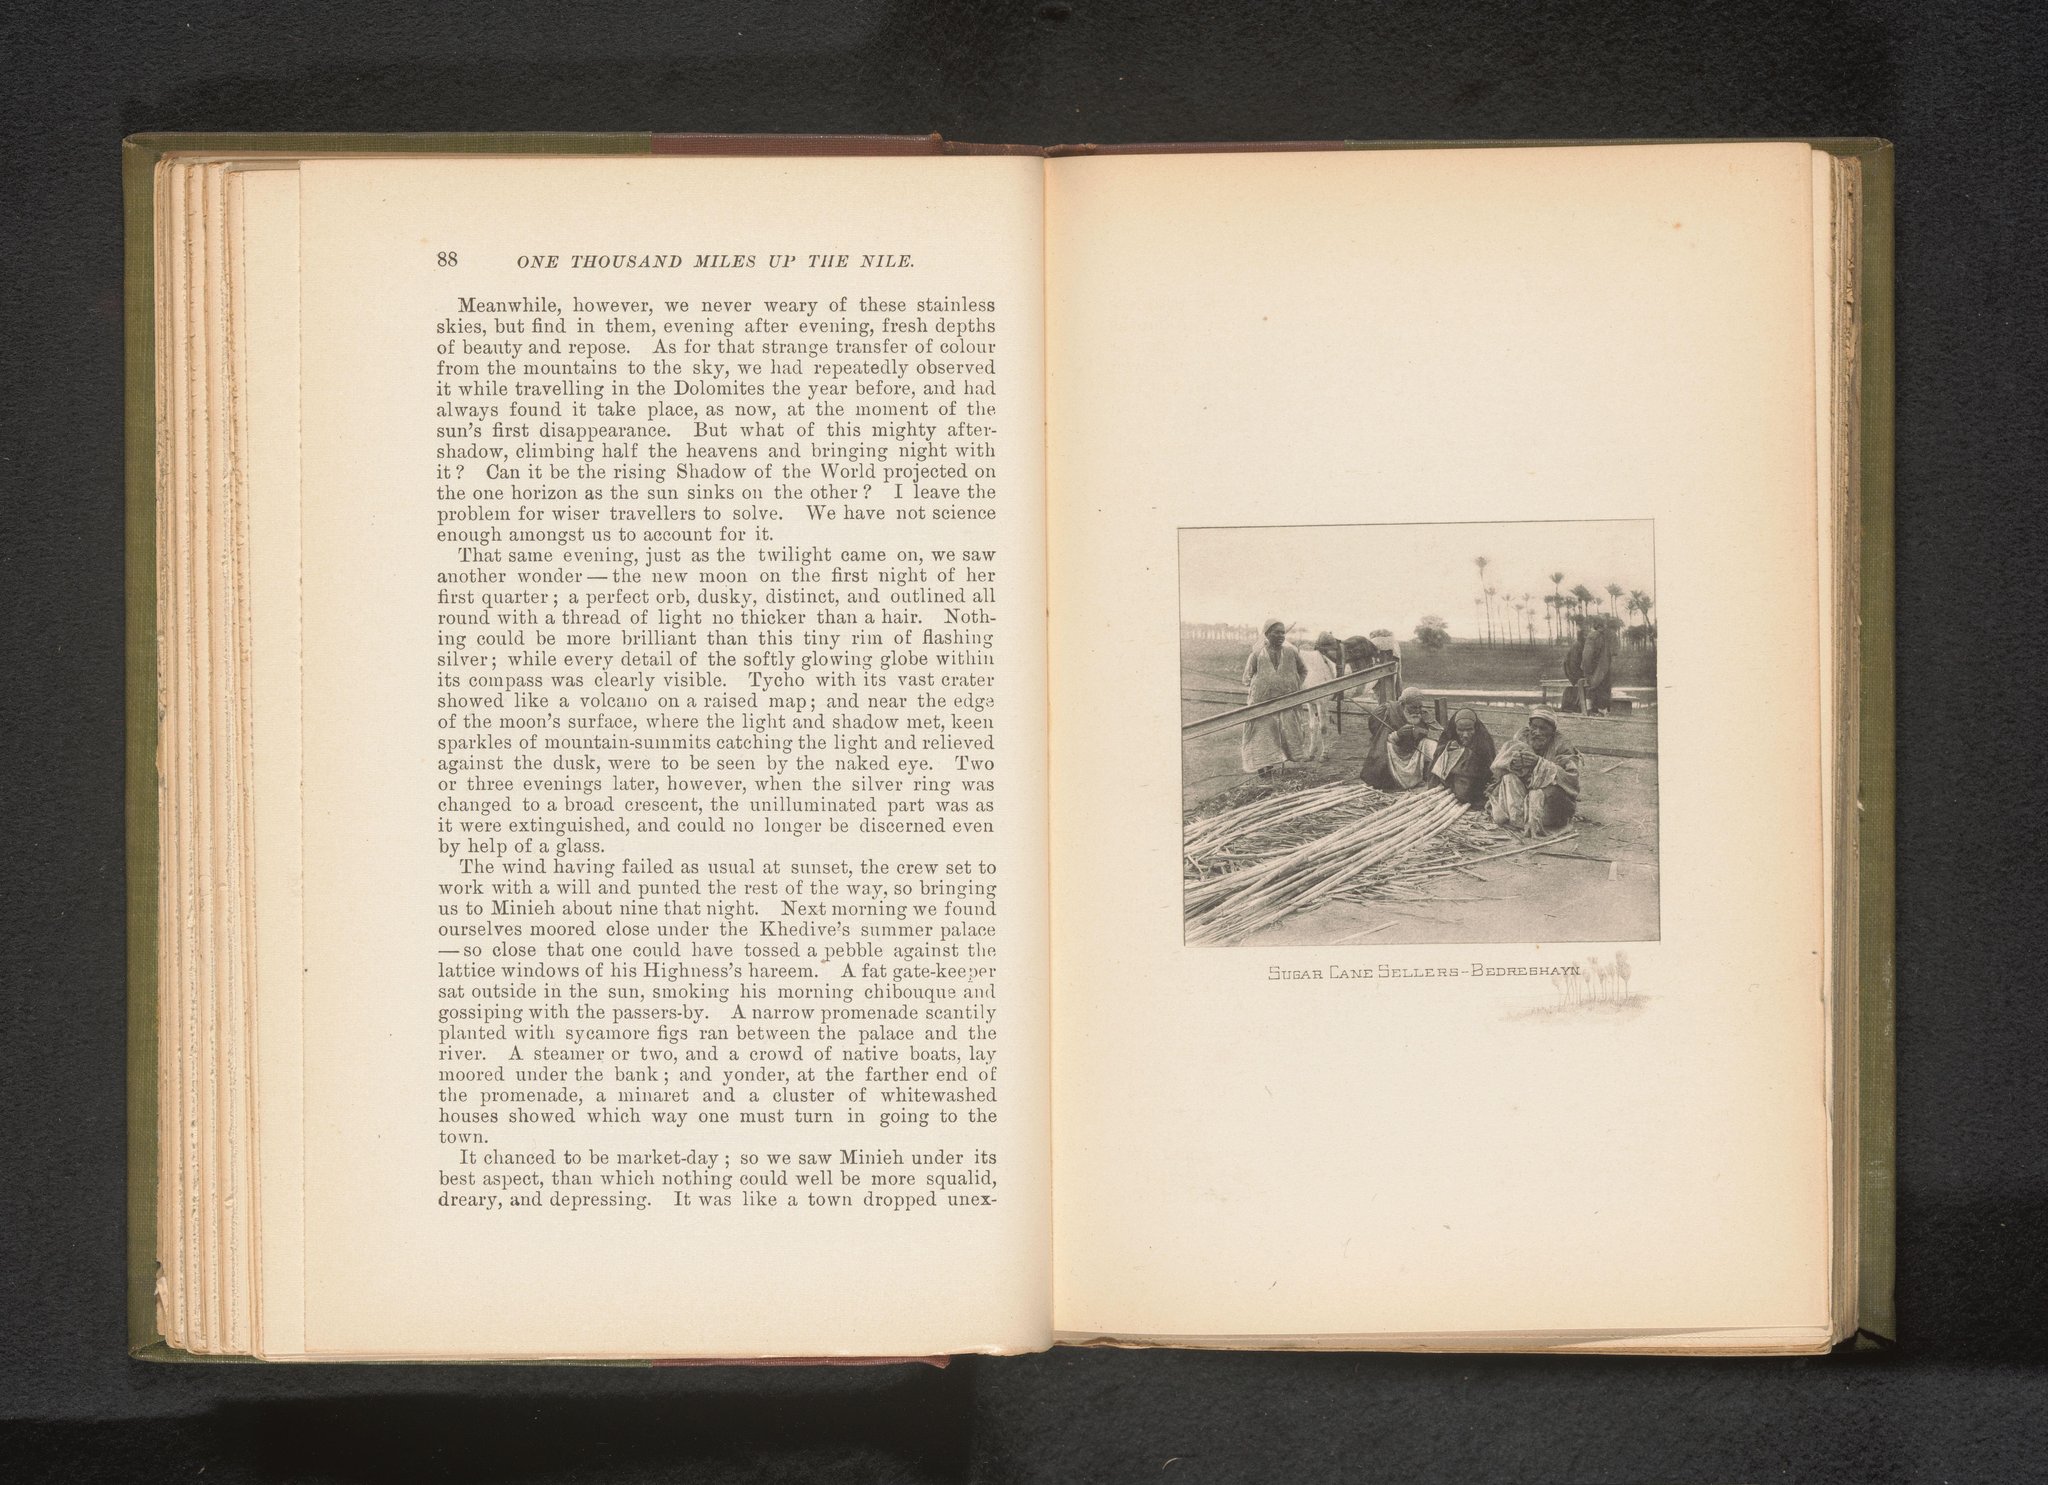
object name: photomechanical print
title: Sugar cane-sellers-Bedreshayn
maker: Anonymous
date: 1884-1894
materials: paper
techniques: photoaquatint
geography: egypt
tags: plants and herbs: sugarcane, merchant, salesman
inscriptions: annotation